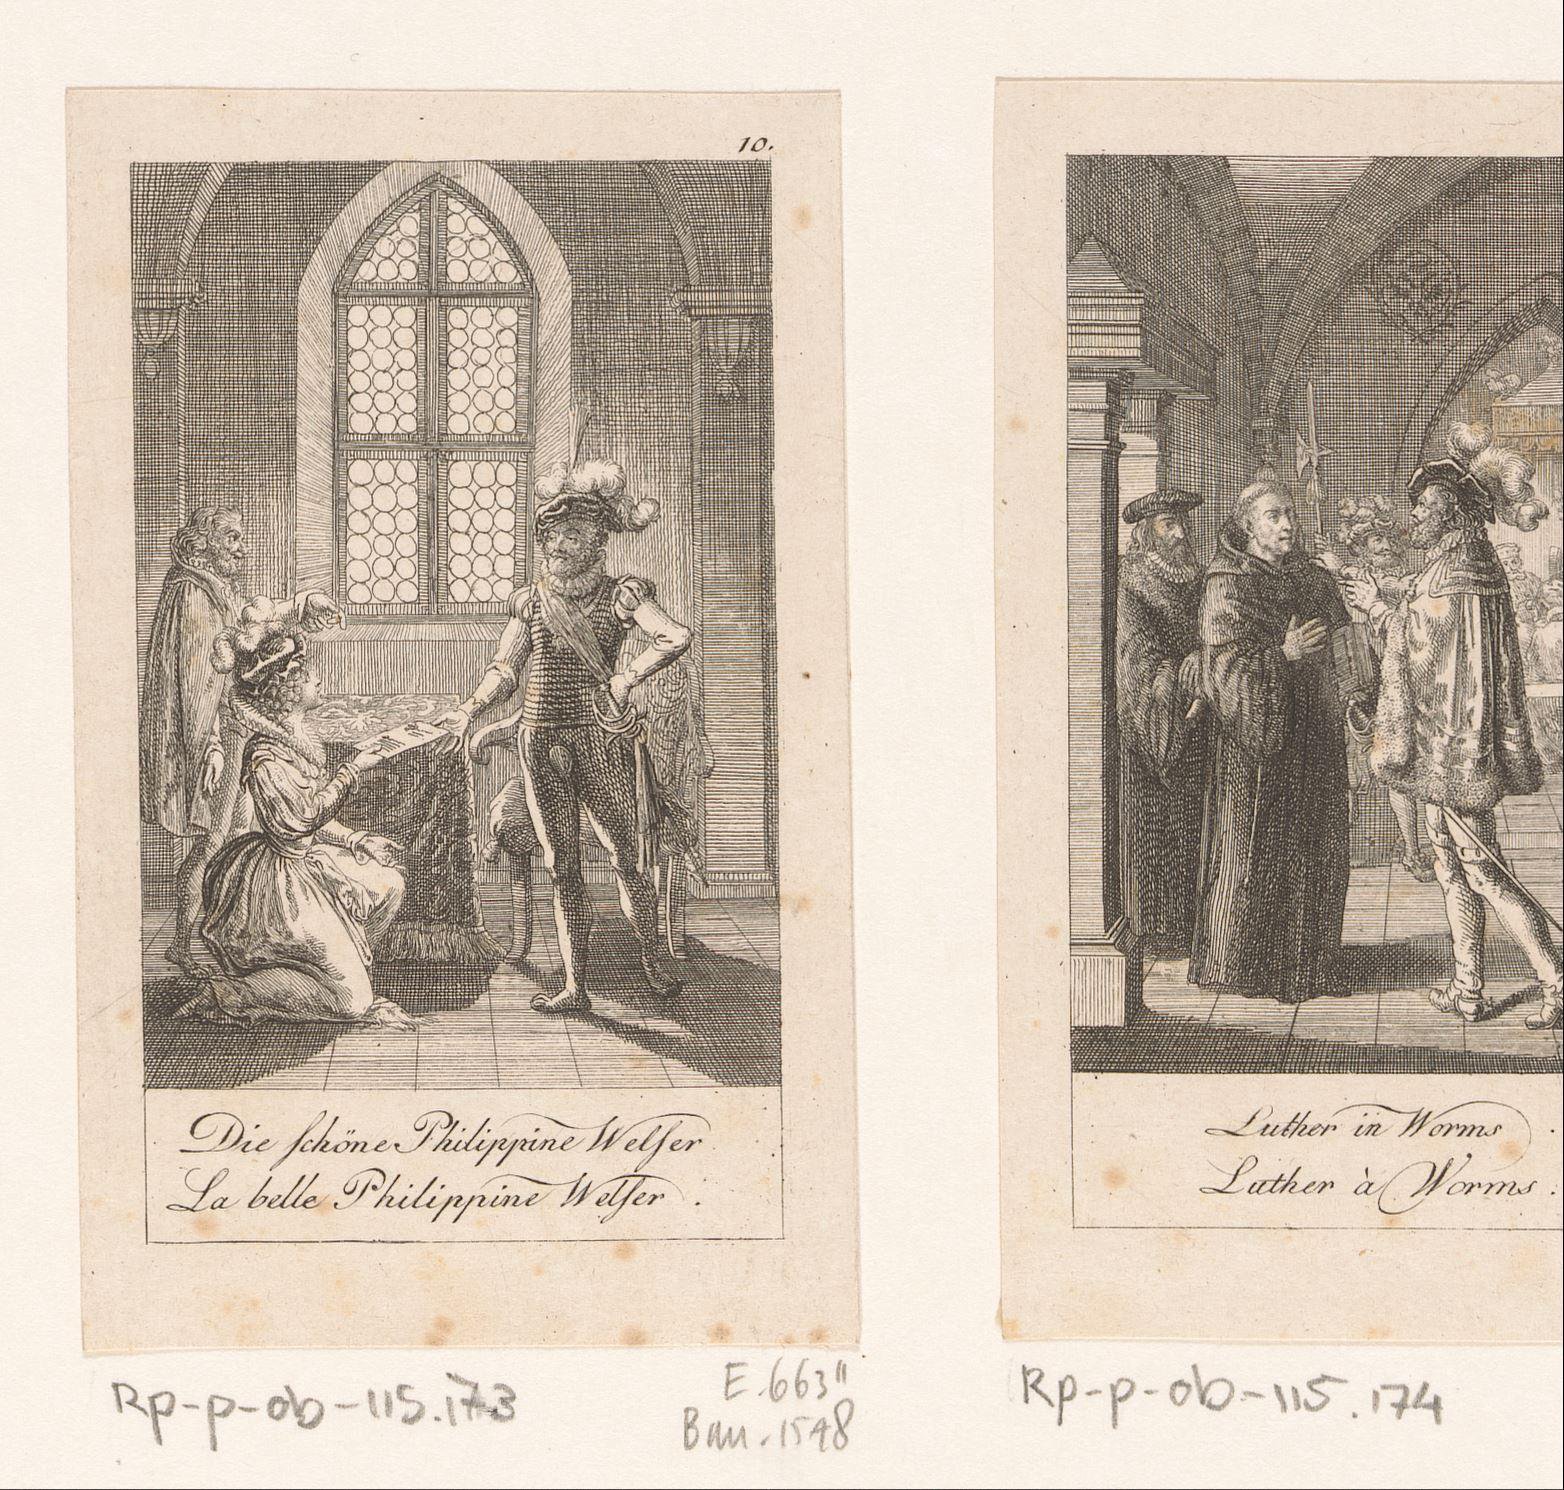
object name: book illustration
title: Philippine Welser knielt voor Ferdinand II van Tirol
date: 1791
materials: paper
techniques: etching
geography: gotha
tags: ferdinand ii van tirol, augsburg, kneeling figure - aa - female human figure, history, betrothal and marriage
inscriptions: collector's mark: Lugt 2228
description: Prent gebruikt voor: Gothaischer Hof Kalender, zum Nutzen und Vergnügen auf das Jahr 1792. Gotha: C. W. Ettinger, [1791].